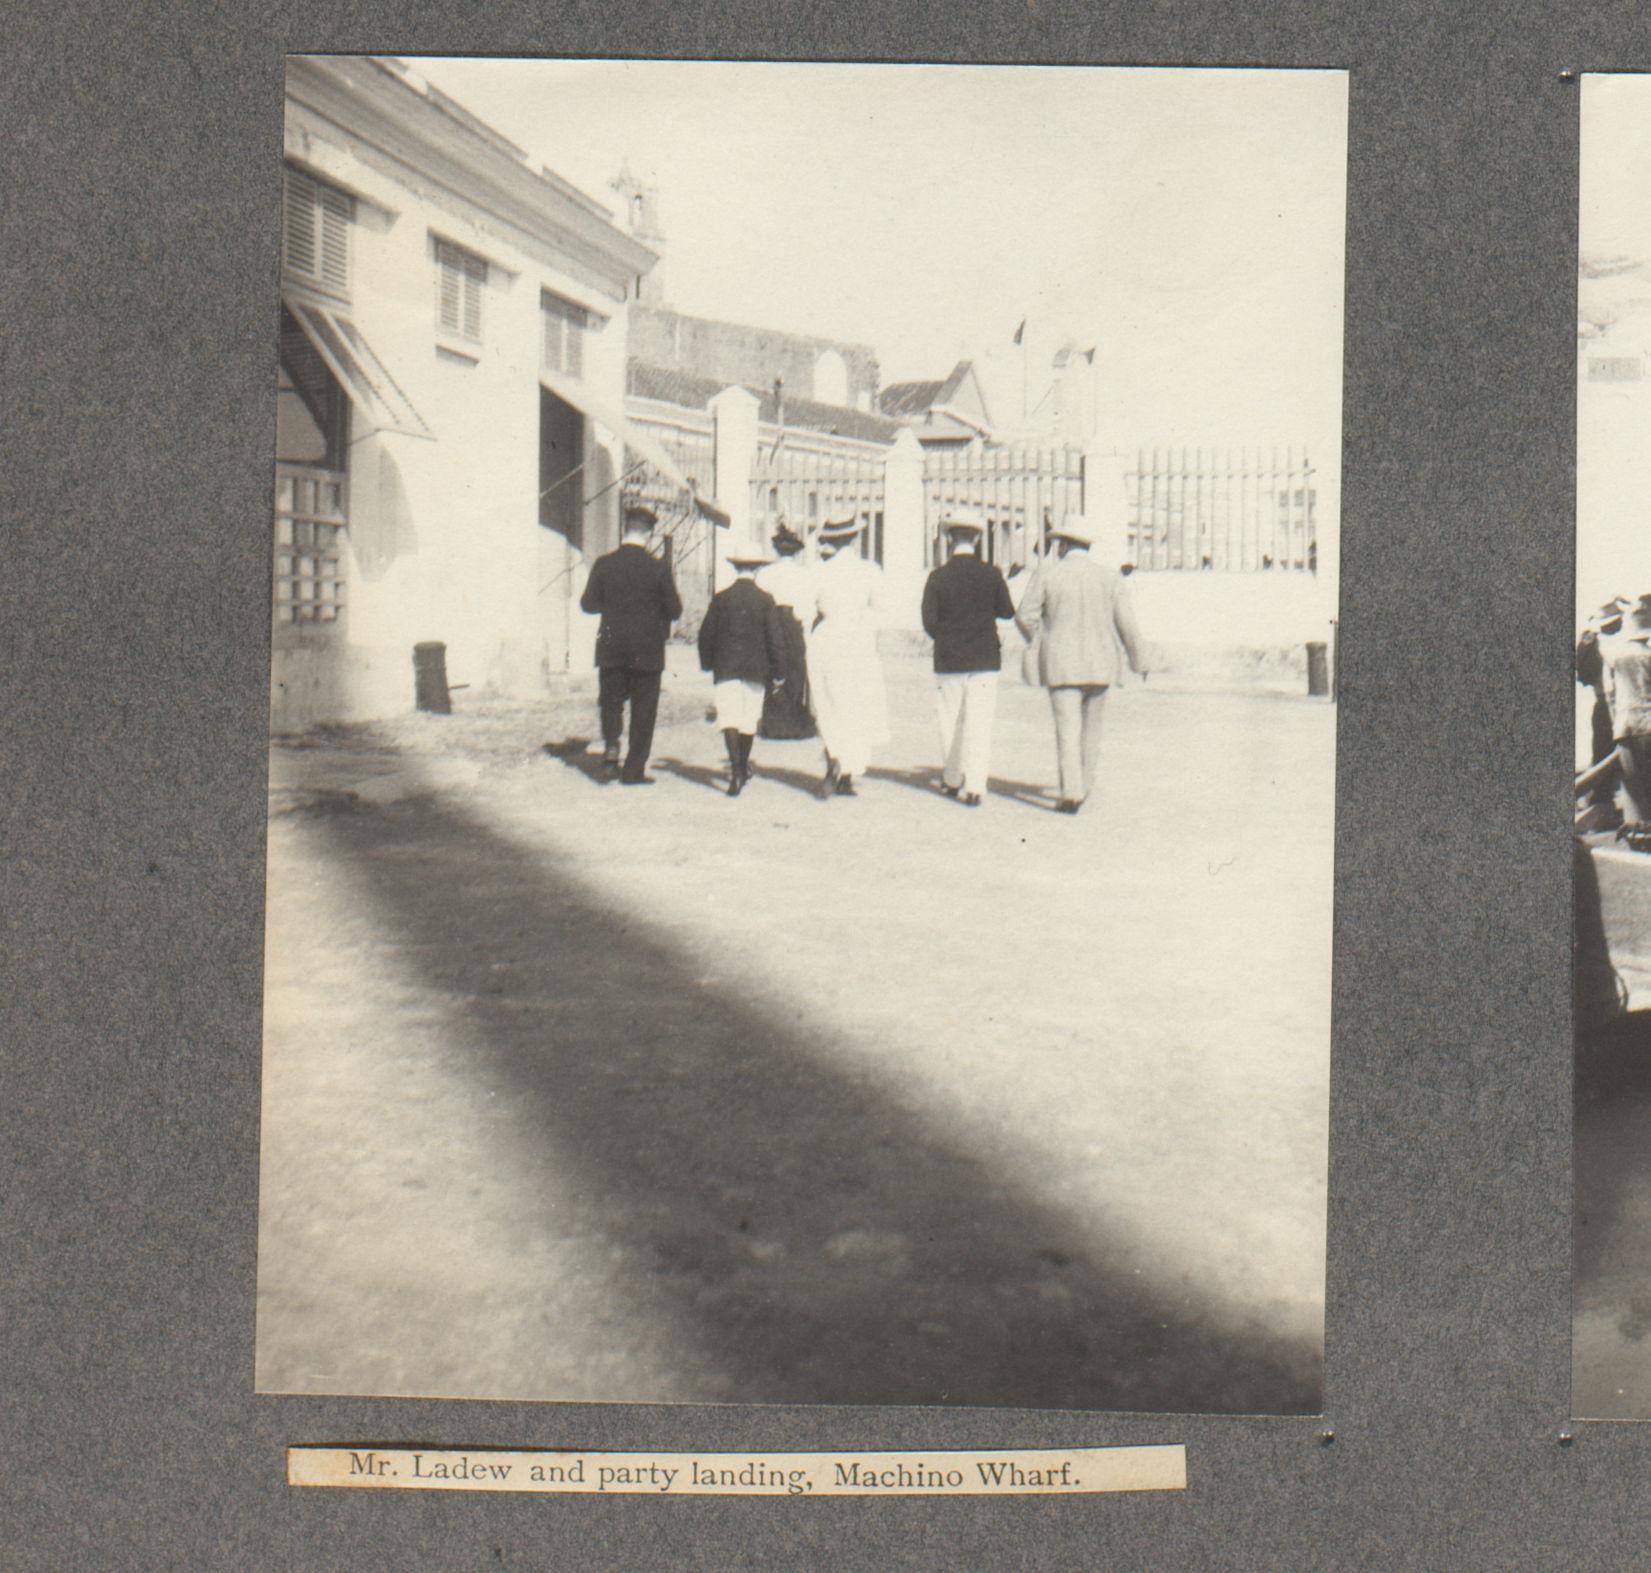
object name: album leaf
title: Mr. Ladew and party landing, Machino Wharf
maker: Anonymous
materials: paper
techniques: platinum process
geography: havana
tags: joseph harvey ladew sr., historical persons, walking, pier, quay, wharf